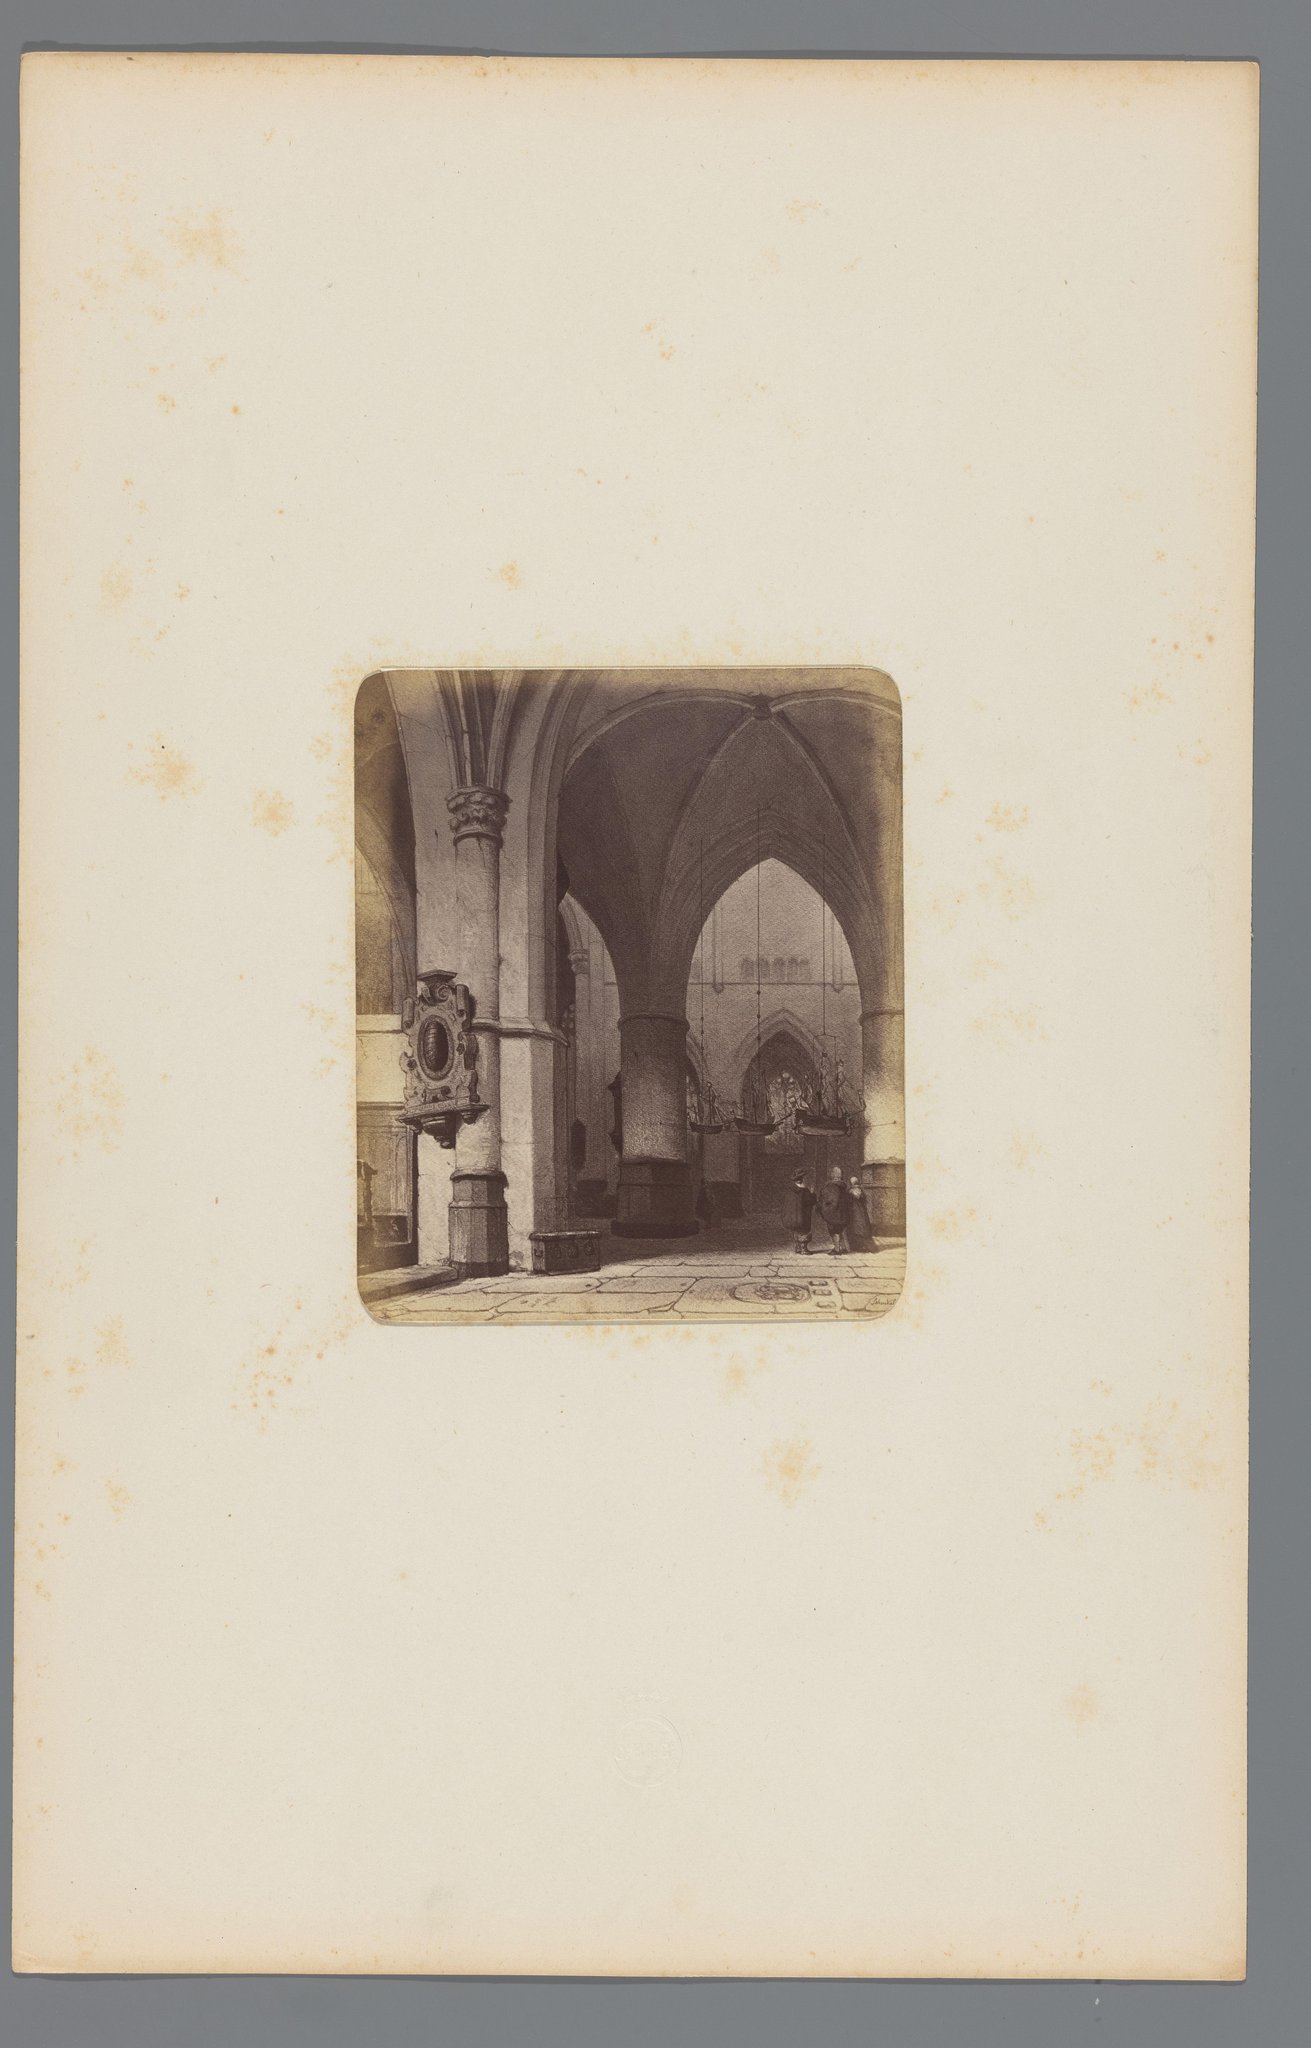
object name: reproduction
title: Fotoreproductie van het schilderij 'In de kerk te Haarlem' door Jan Jacob Schenkel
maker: jan jacob schenkel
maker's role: painter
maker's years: 1829-1900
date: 1866-1871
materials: paper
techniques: albumen print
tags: interior of church, haarlem